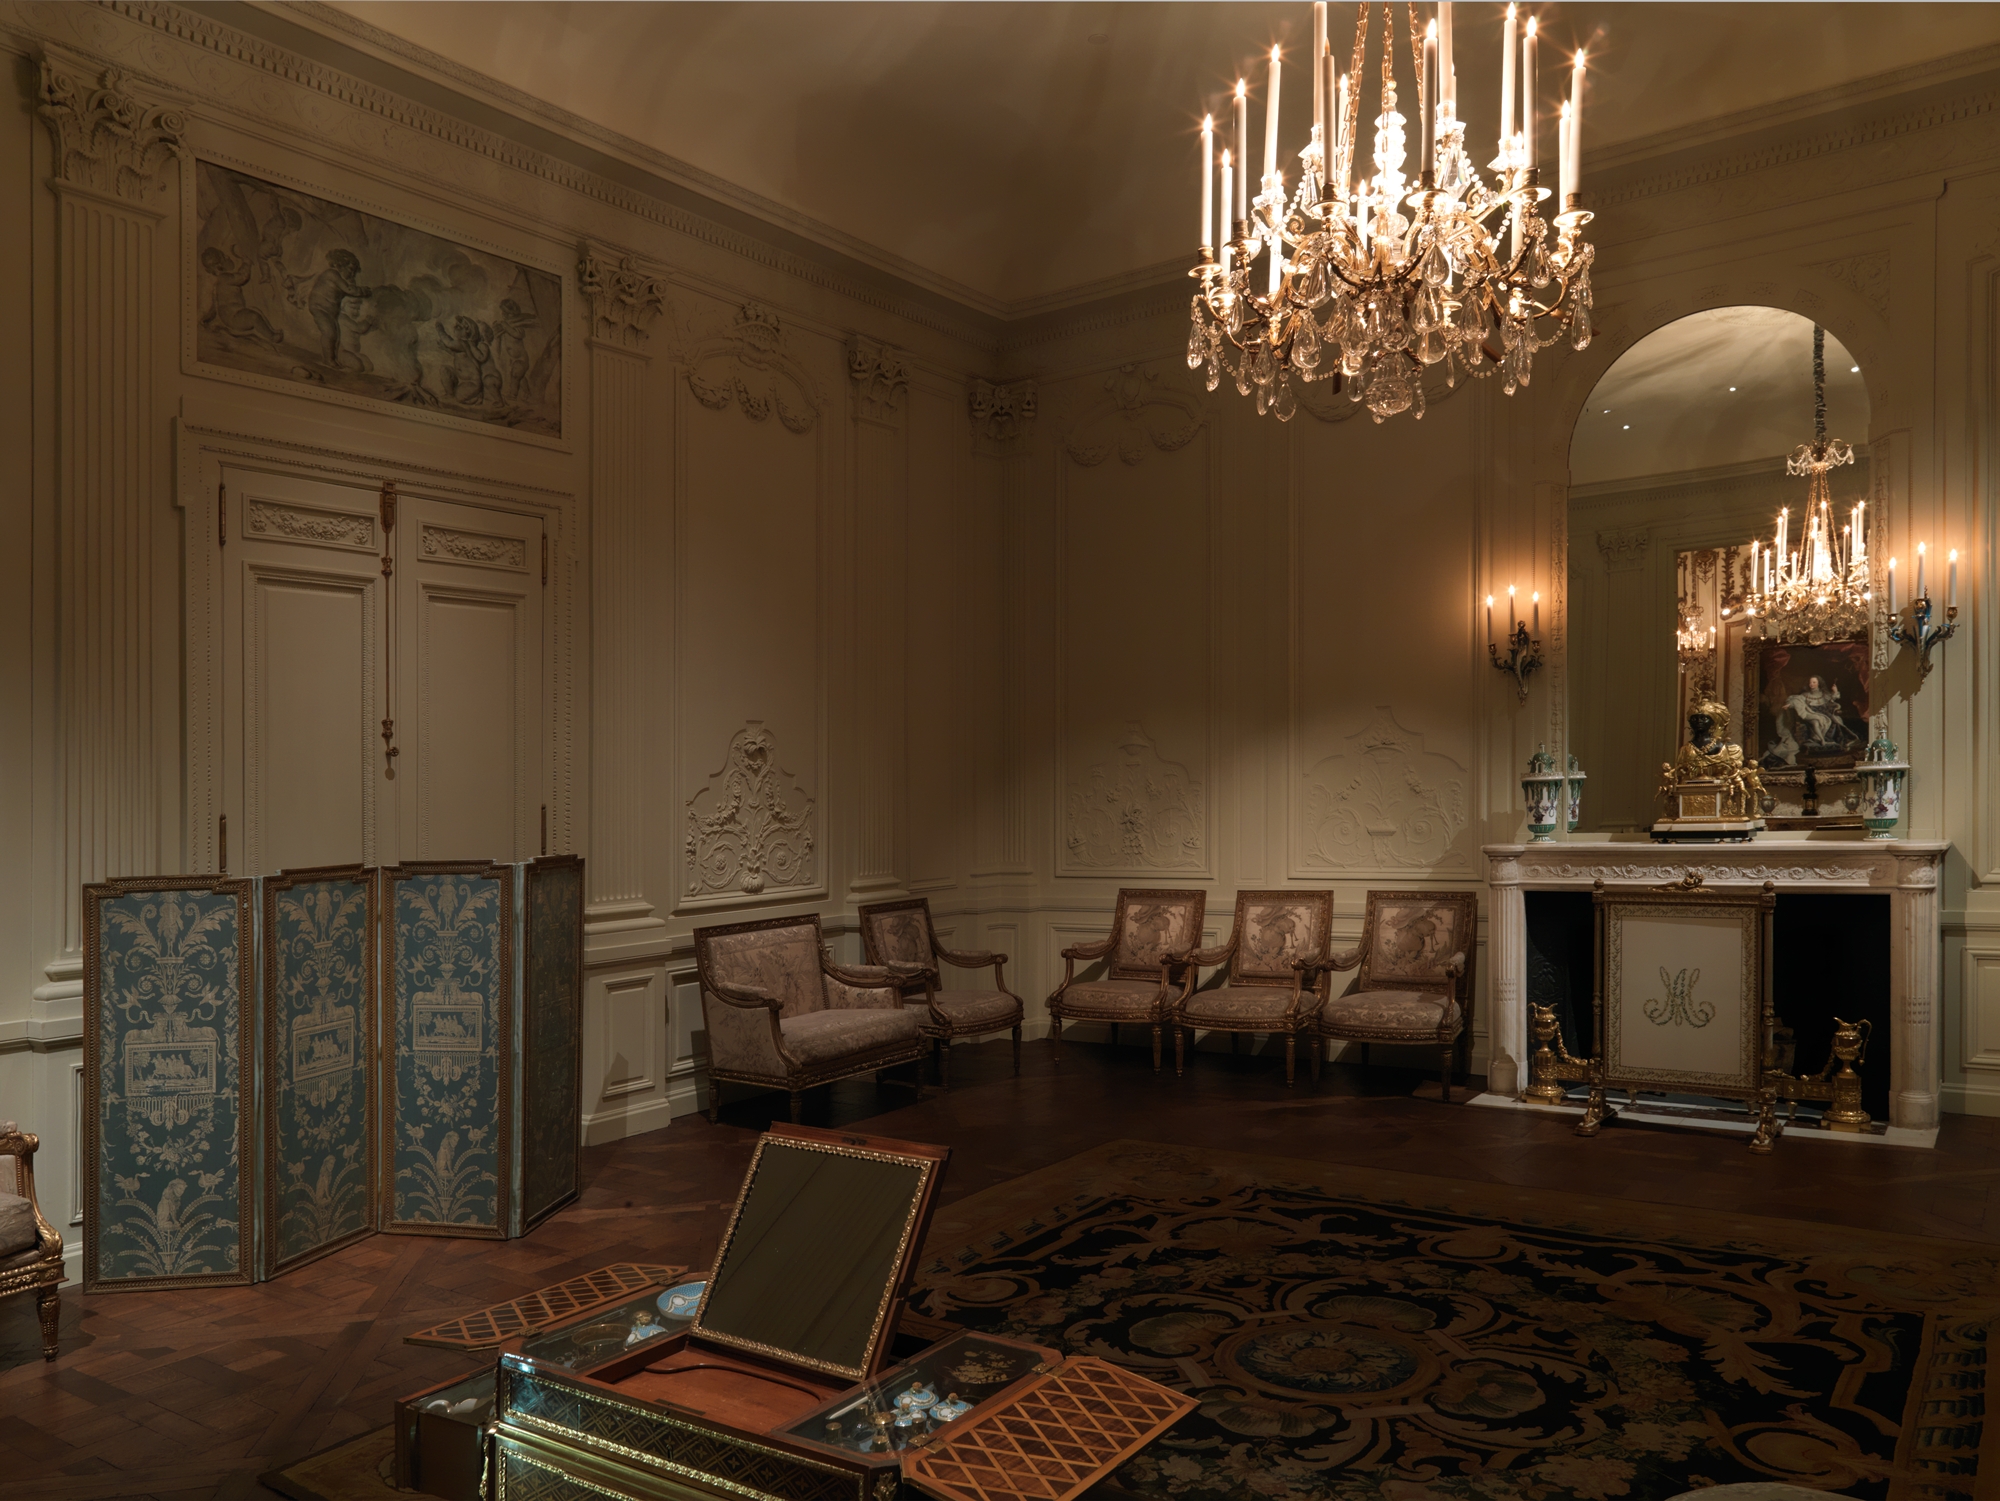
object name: period room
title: Boiserie from the Hôtel Lauzun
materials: wood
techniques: carving, painting